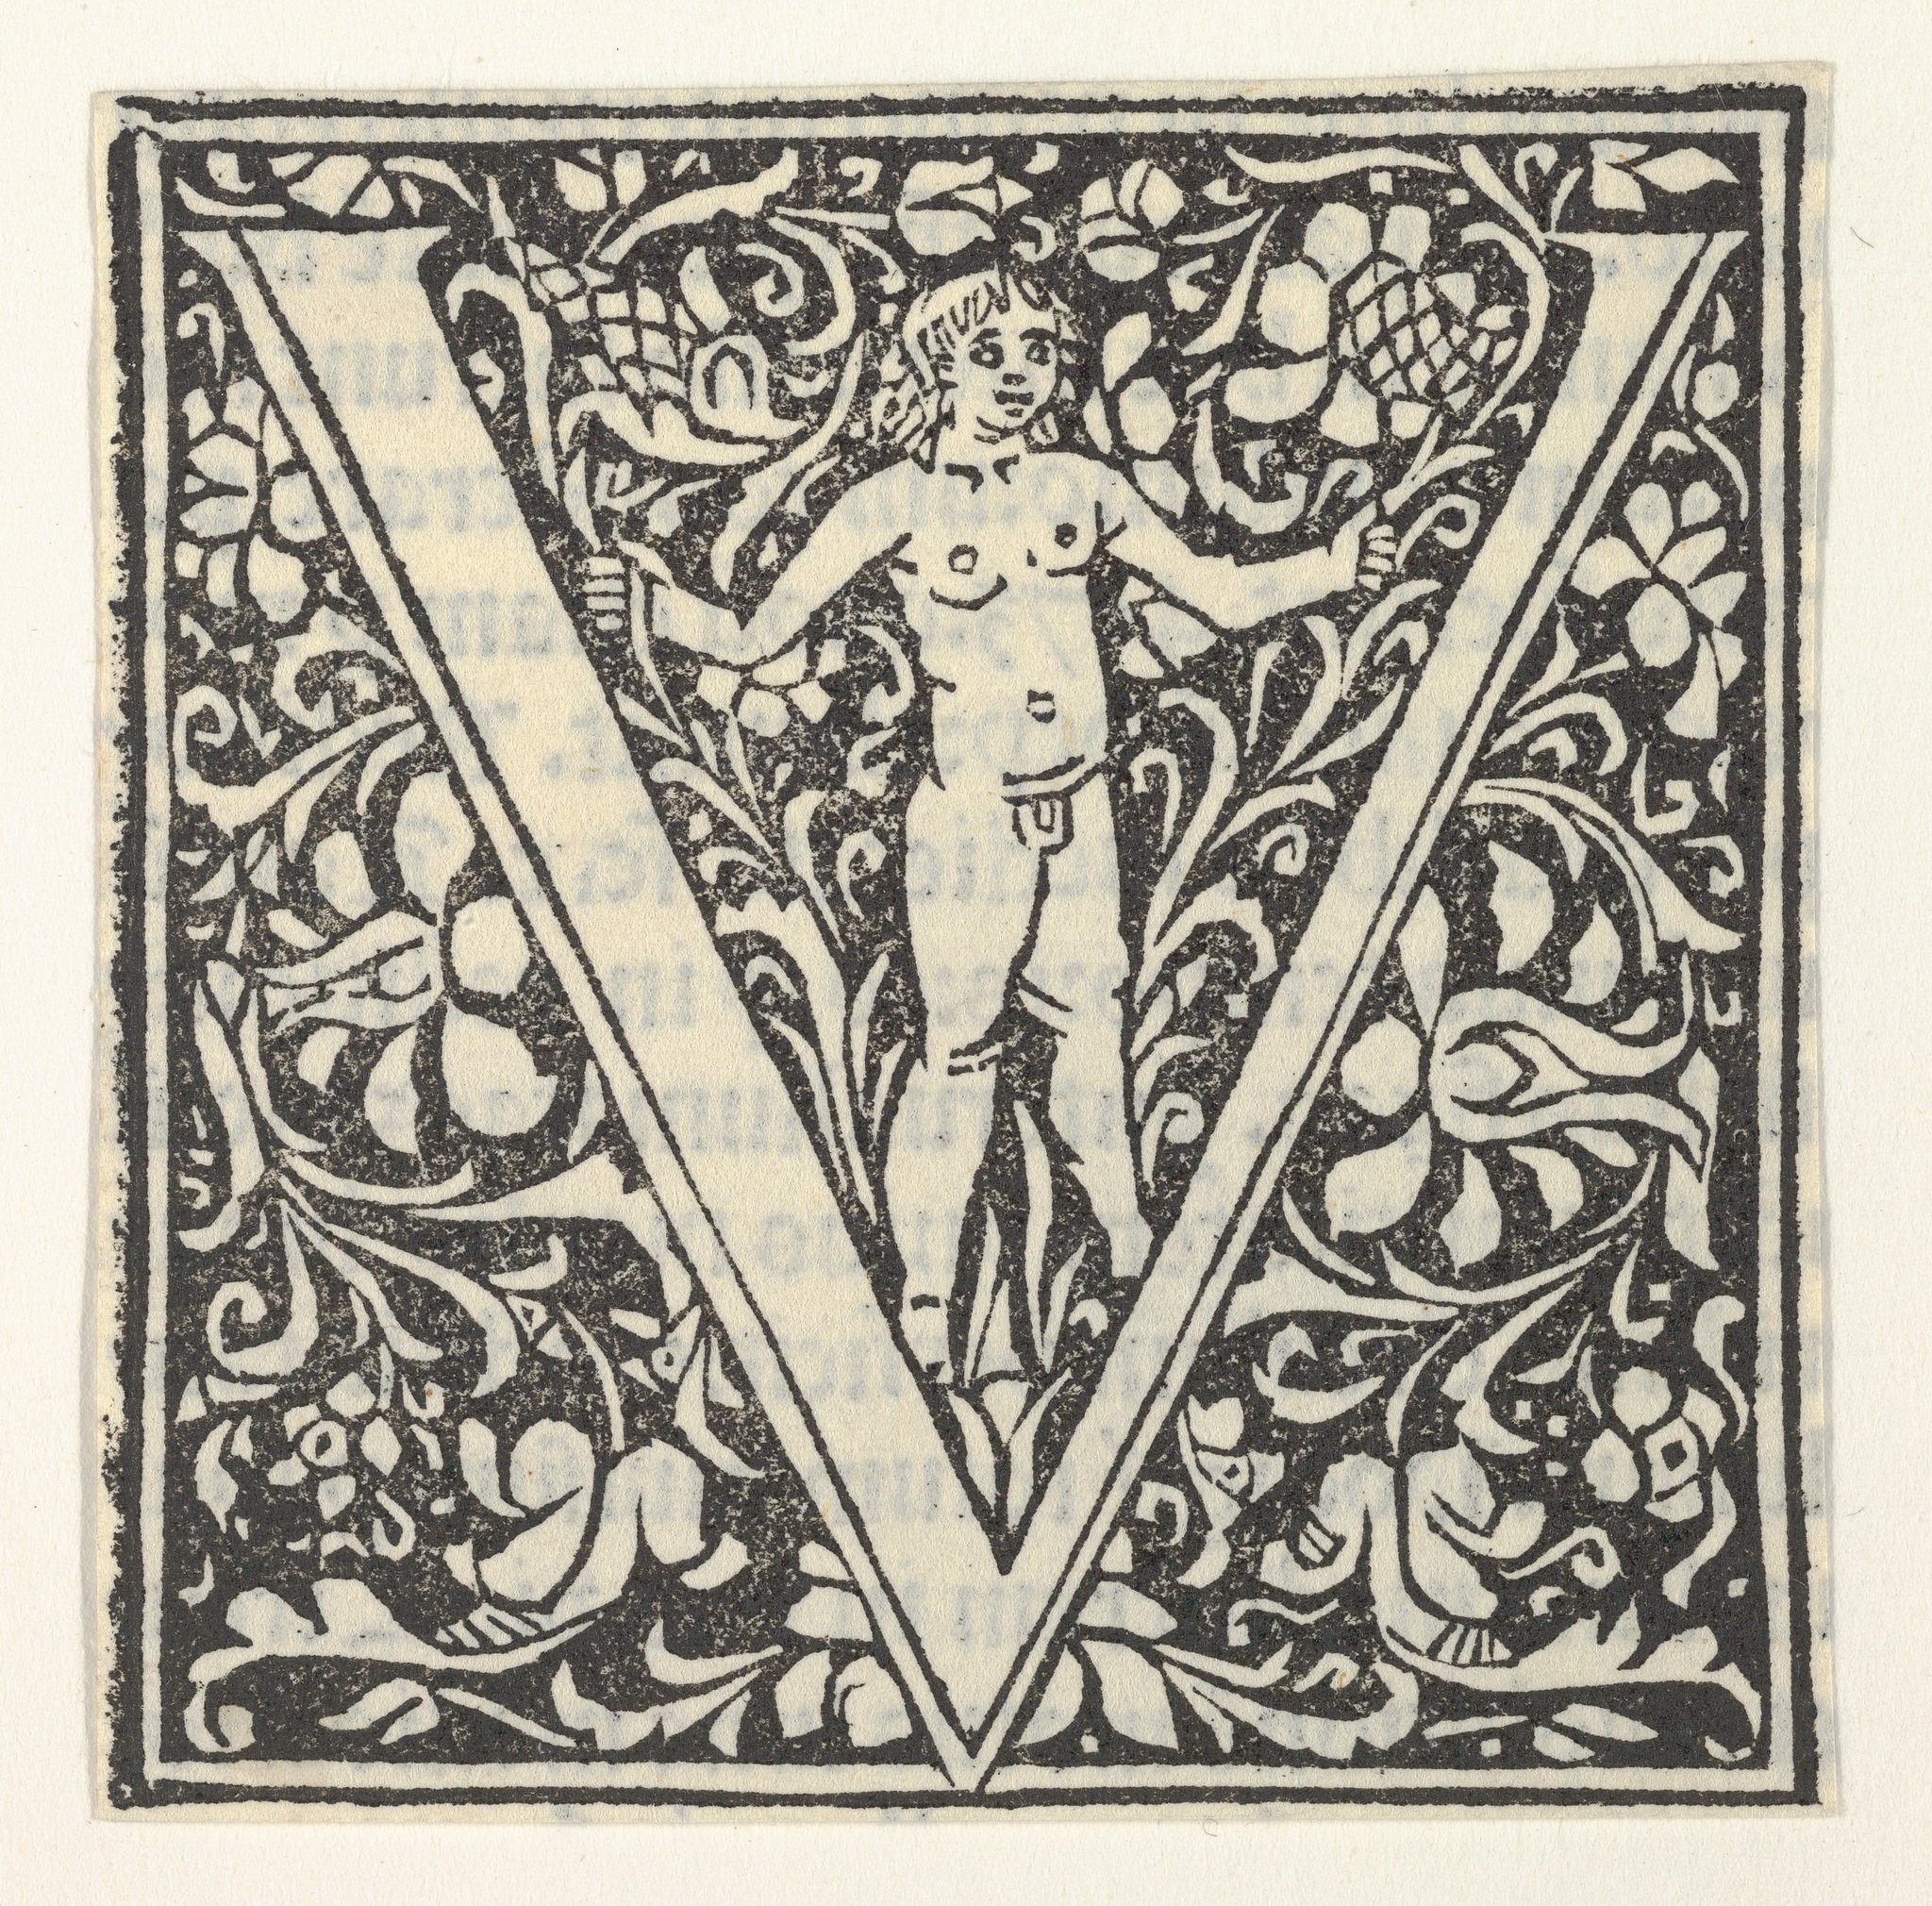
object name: print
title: Initial letter V with putto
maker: anonymous, italian, 15th century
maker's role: artist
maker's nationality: italian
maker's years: 1400-1500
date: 1496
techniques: woodcut